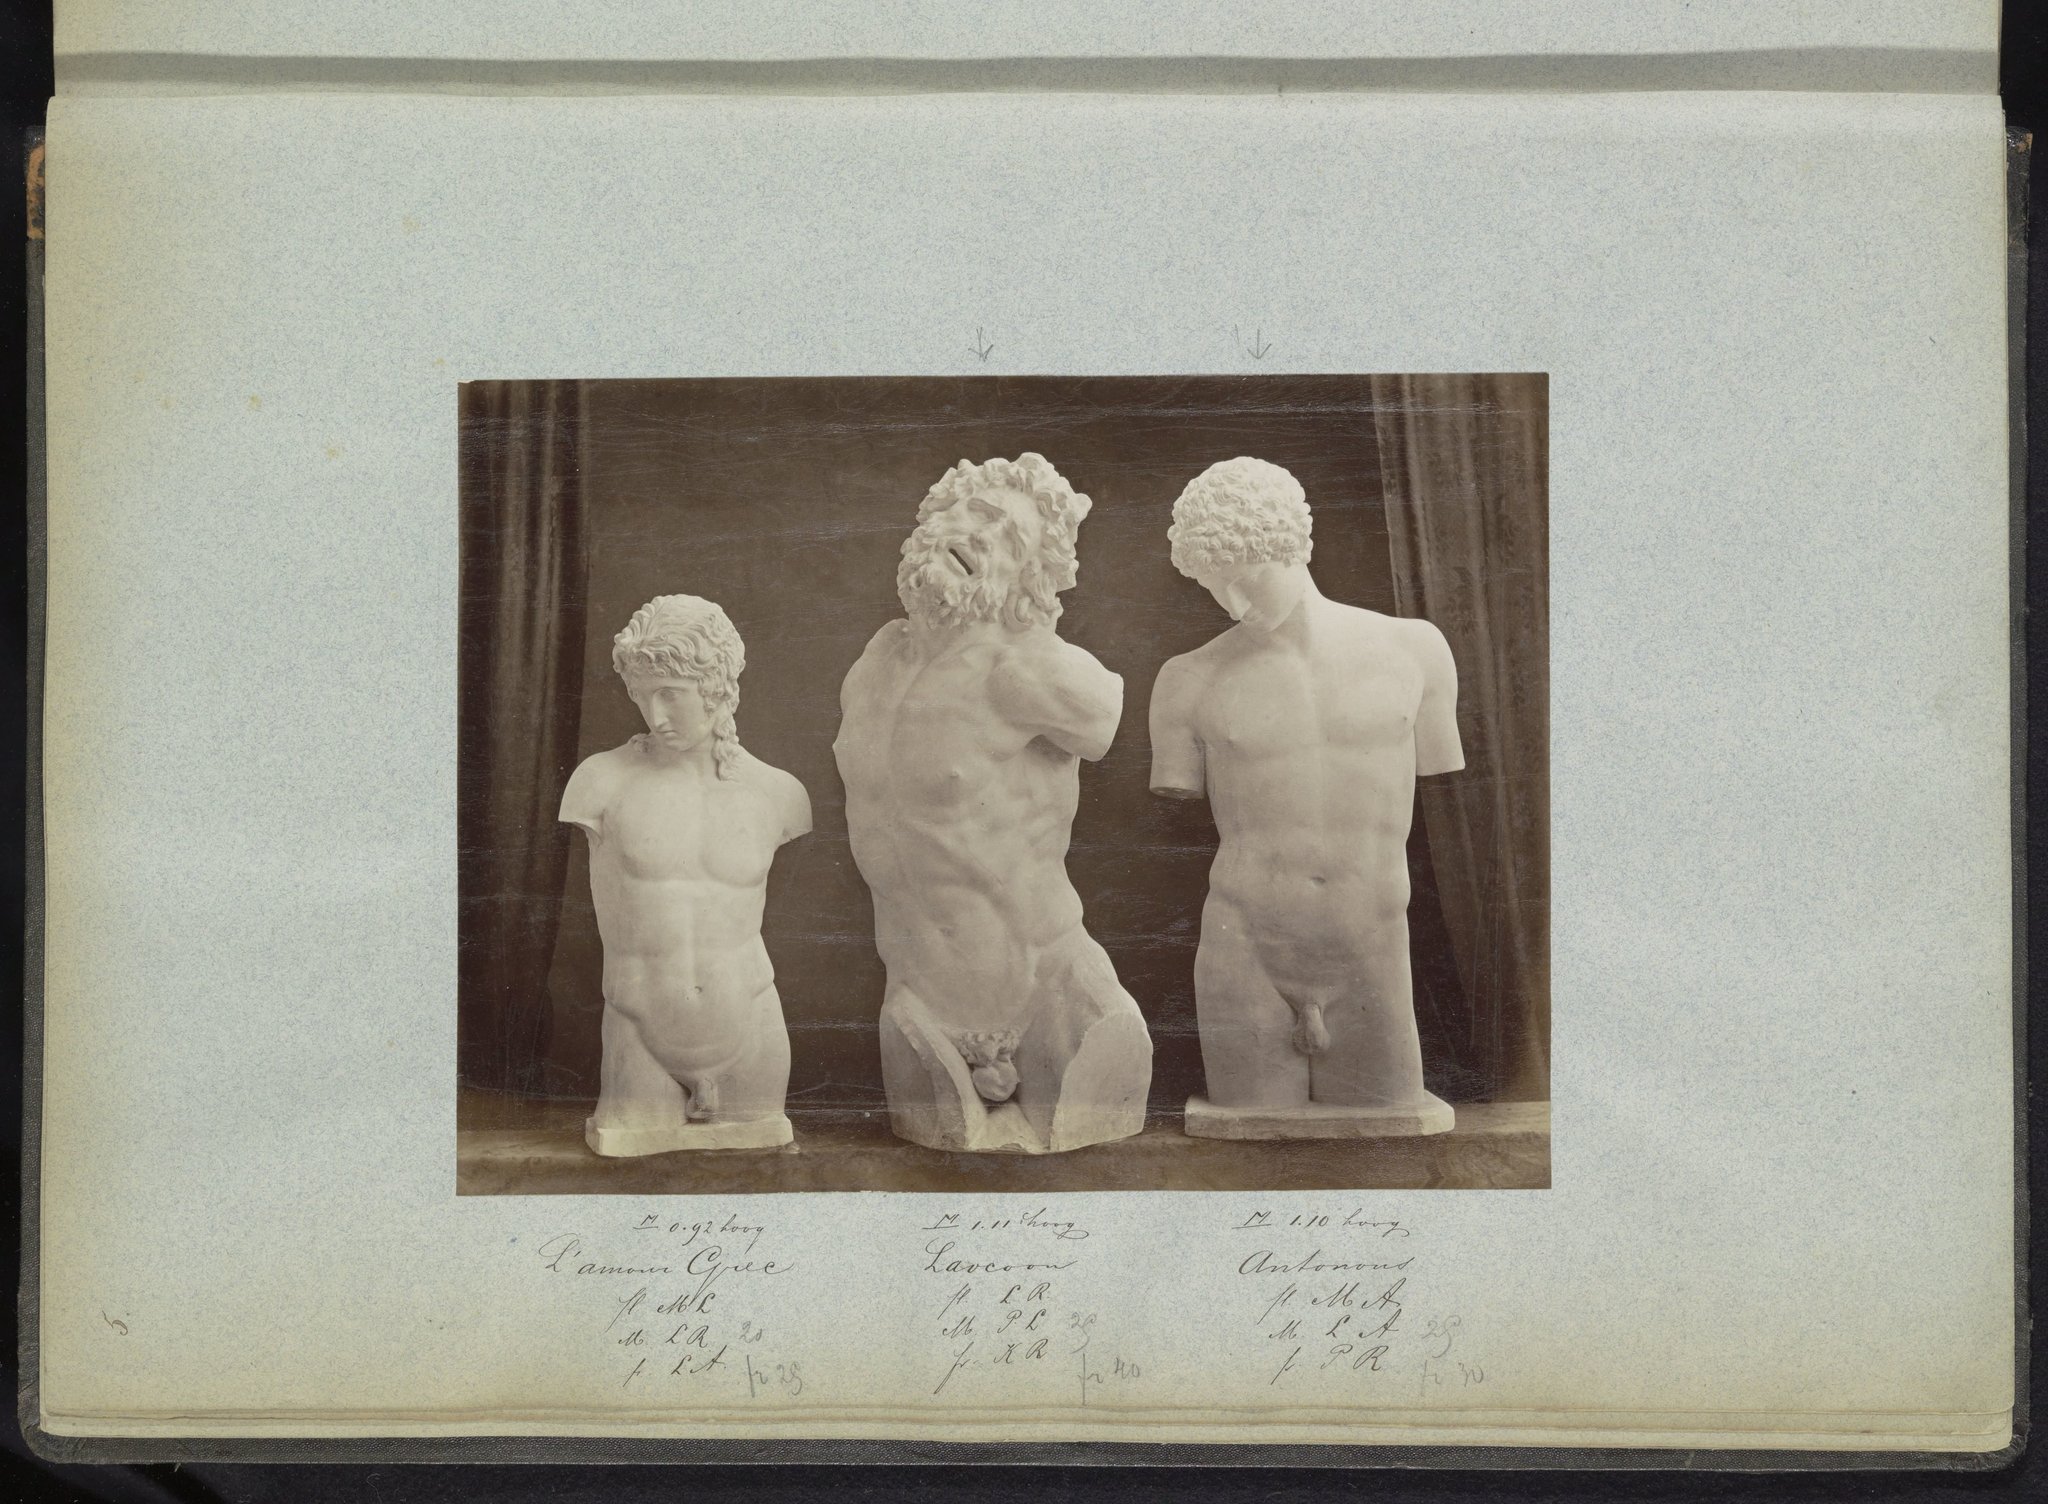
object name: album leaf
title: Drie gipsen afgietsels van sculpturen waaronder de Laocoön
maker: Anonymous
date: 1875-1900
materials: paper, photographic support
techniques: albumen print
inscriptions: annotation: ‘M 1.10 hoog / [...]’, annotation: ‘M 1.11 hoog / Laocoon’, annotation: ‘M 0.92 hoog / L'amour Grec’, annotation